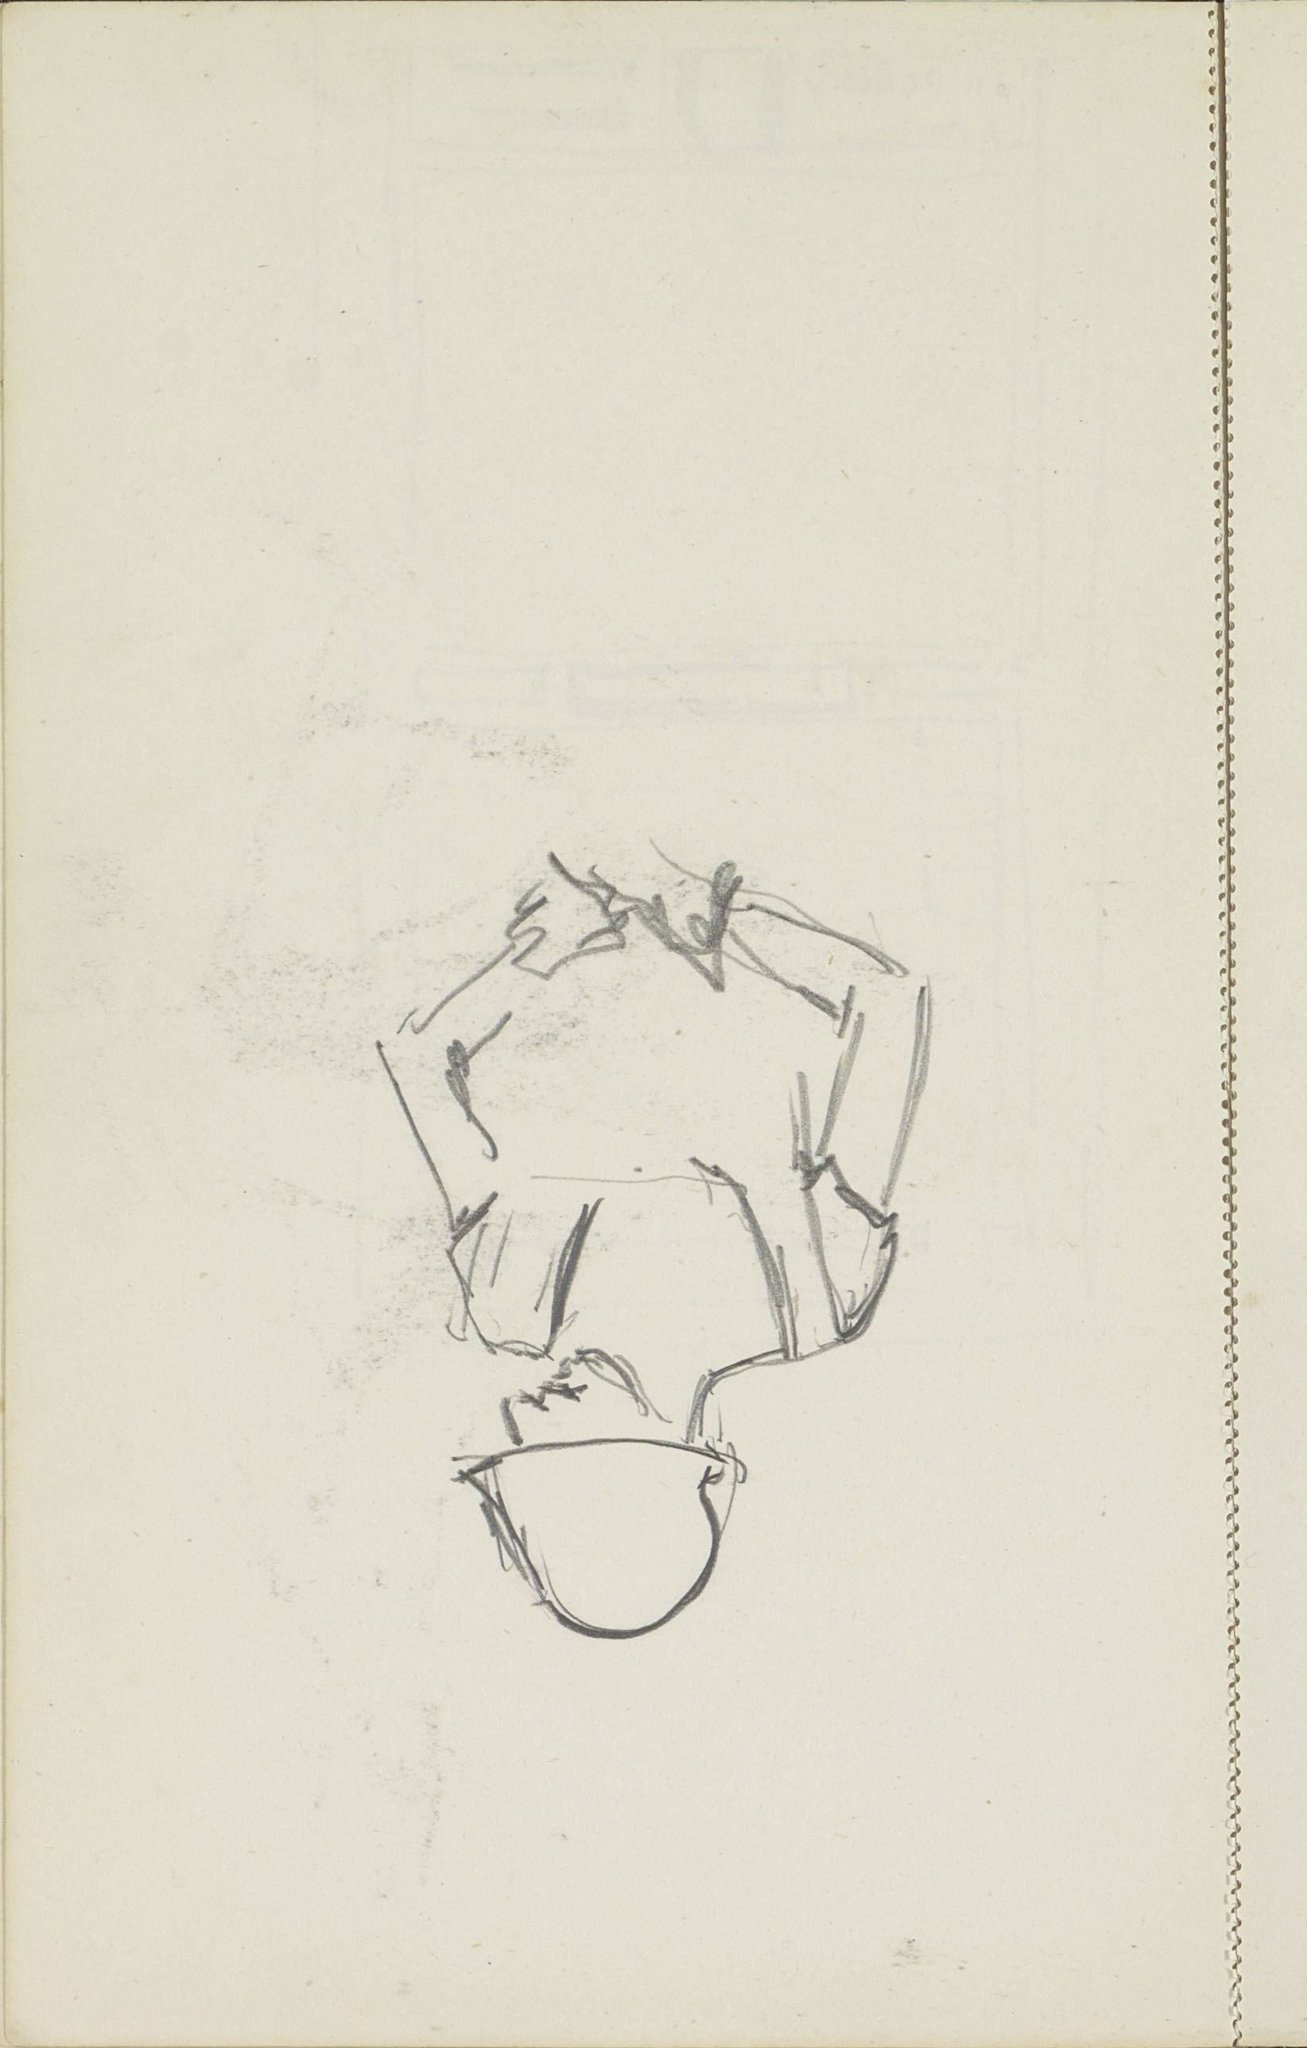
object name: sketchbook leaf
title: Vrouw met een hoed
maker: cornelis vreedenburgh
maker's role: draughtsman, print maker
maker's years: 1880-1946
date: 1890-1946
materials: paper, pencil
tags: adult woman, head-gear: hat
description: Blad 48 verso uit een schetsboek met 50 bladen.